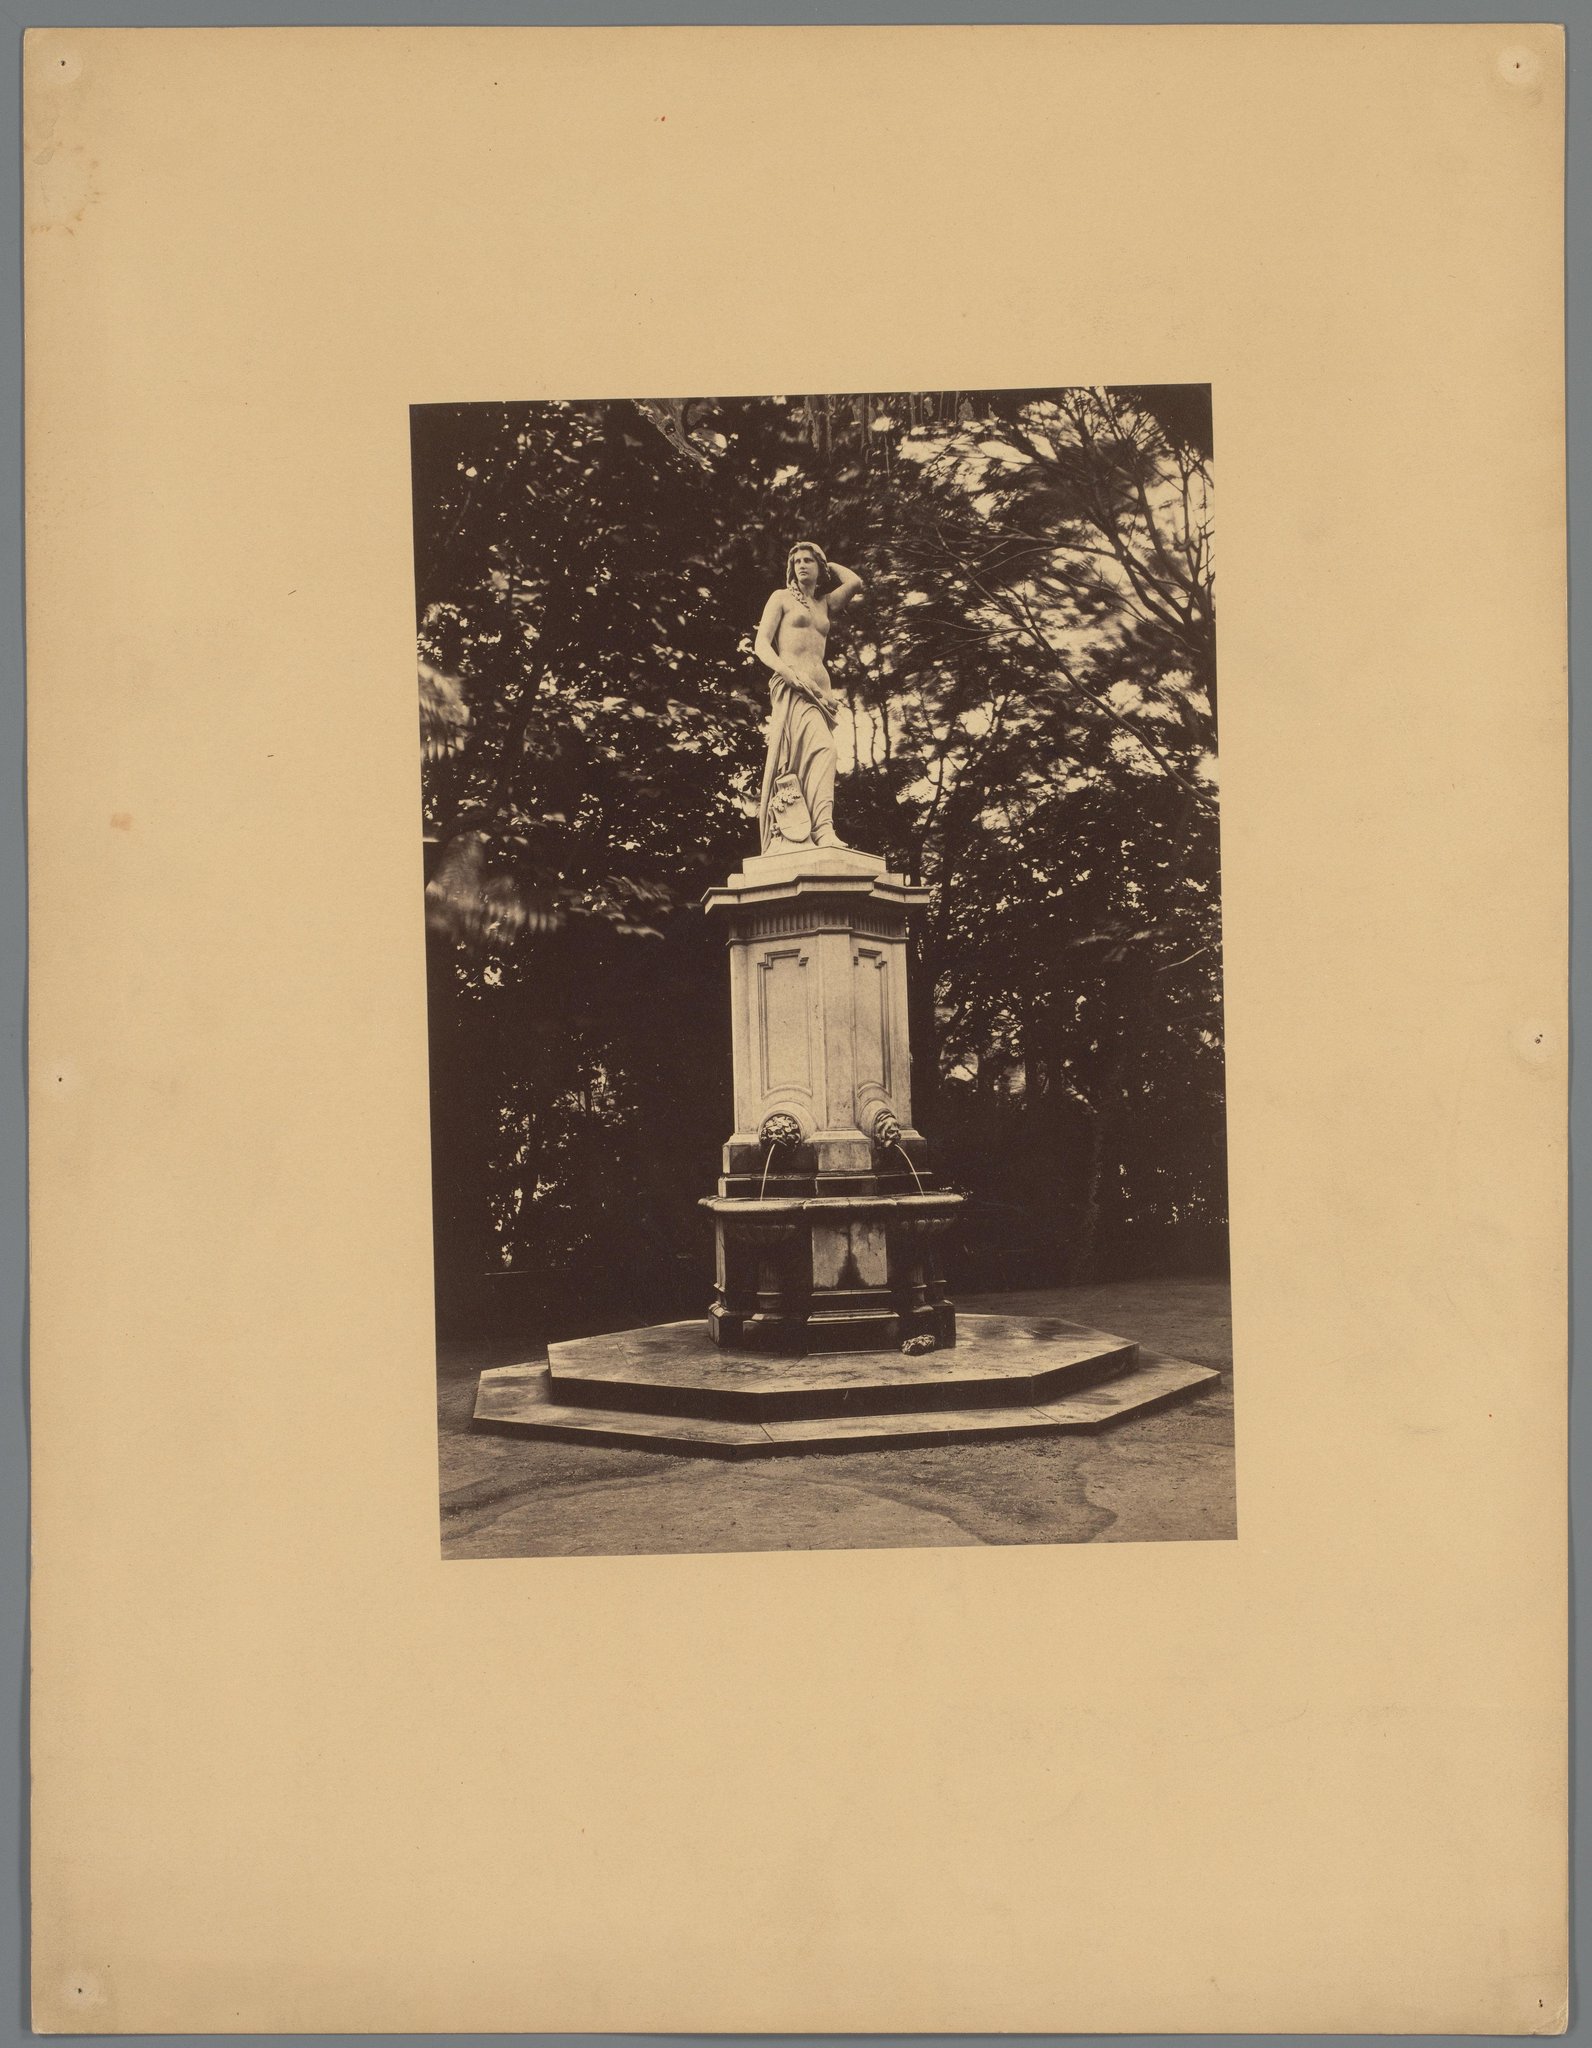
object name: photograph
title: Standbeeld van Danubia, genoemd het Donauweibchen, Wenen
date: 1872-1876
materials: cardboard, paper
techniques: albumen print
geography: vienna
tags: monument, statue, ornamental fountain, vienna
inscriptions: inscription: ‘Nr. 25. (...) Vervielfältigung vorbehalten.’